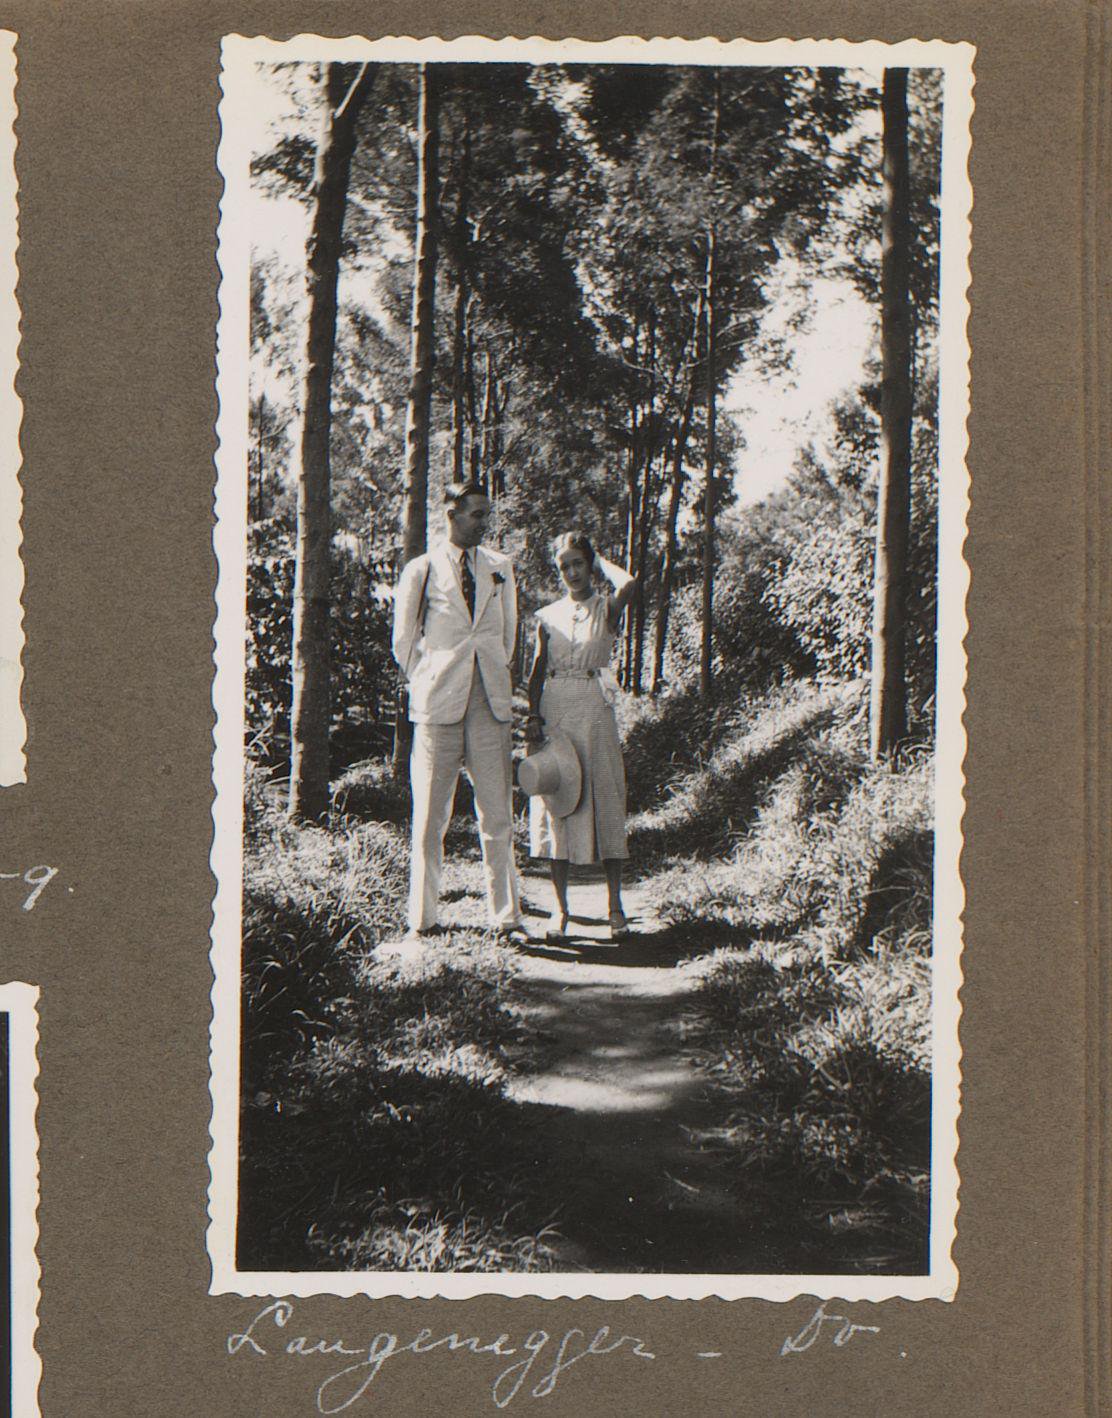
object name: photograph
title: Dootje van Zijll de Jong en een man, nabij Bandoeng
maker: Anonymous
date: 1933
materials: paper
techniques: gelatin silver print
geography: west java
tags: amsterdam, historical persons, forest path or lane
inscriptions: inscription: ‘Langenegger - Do.’